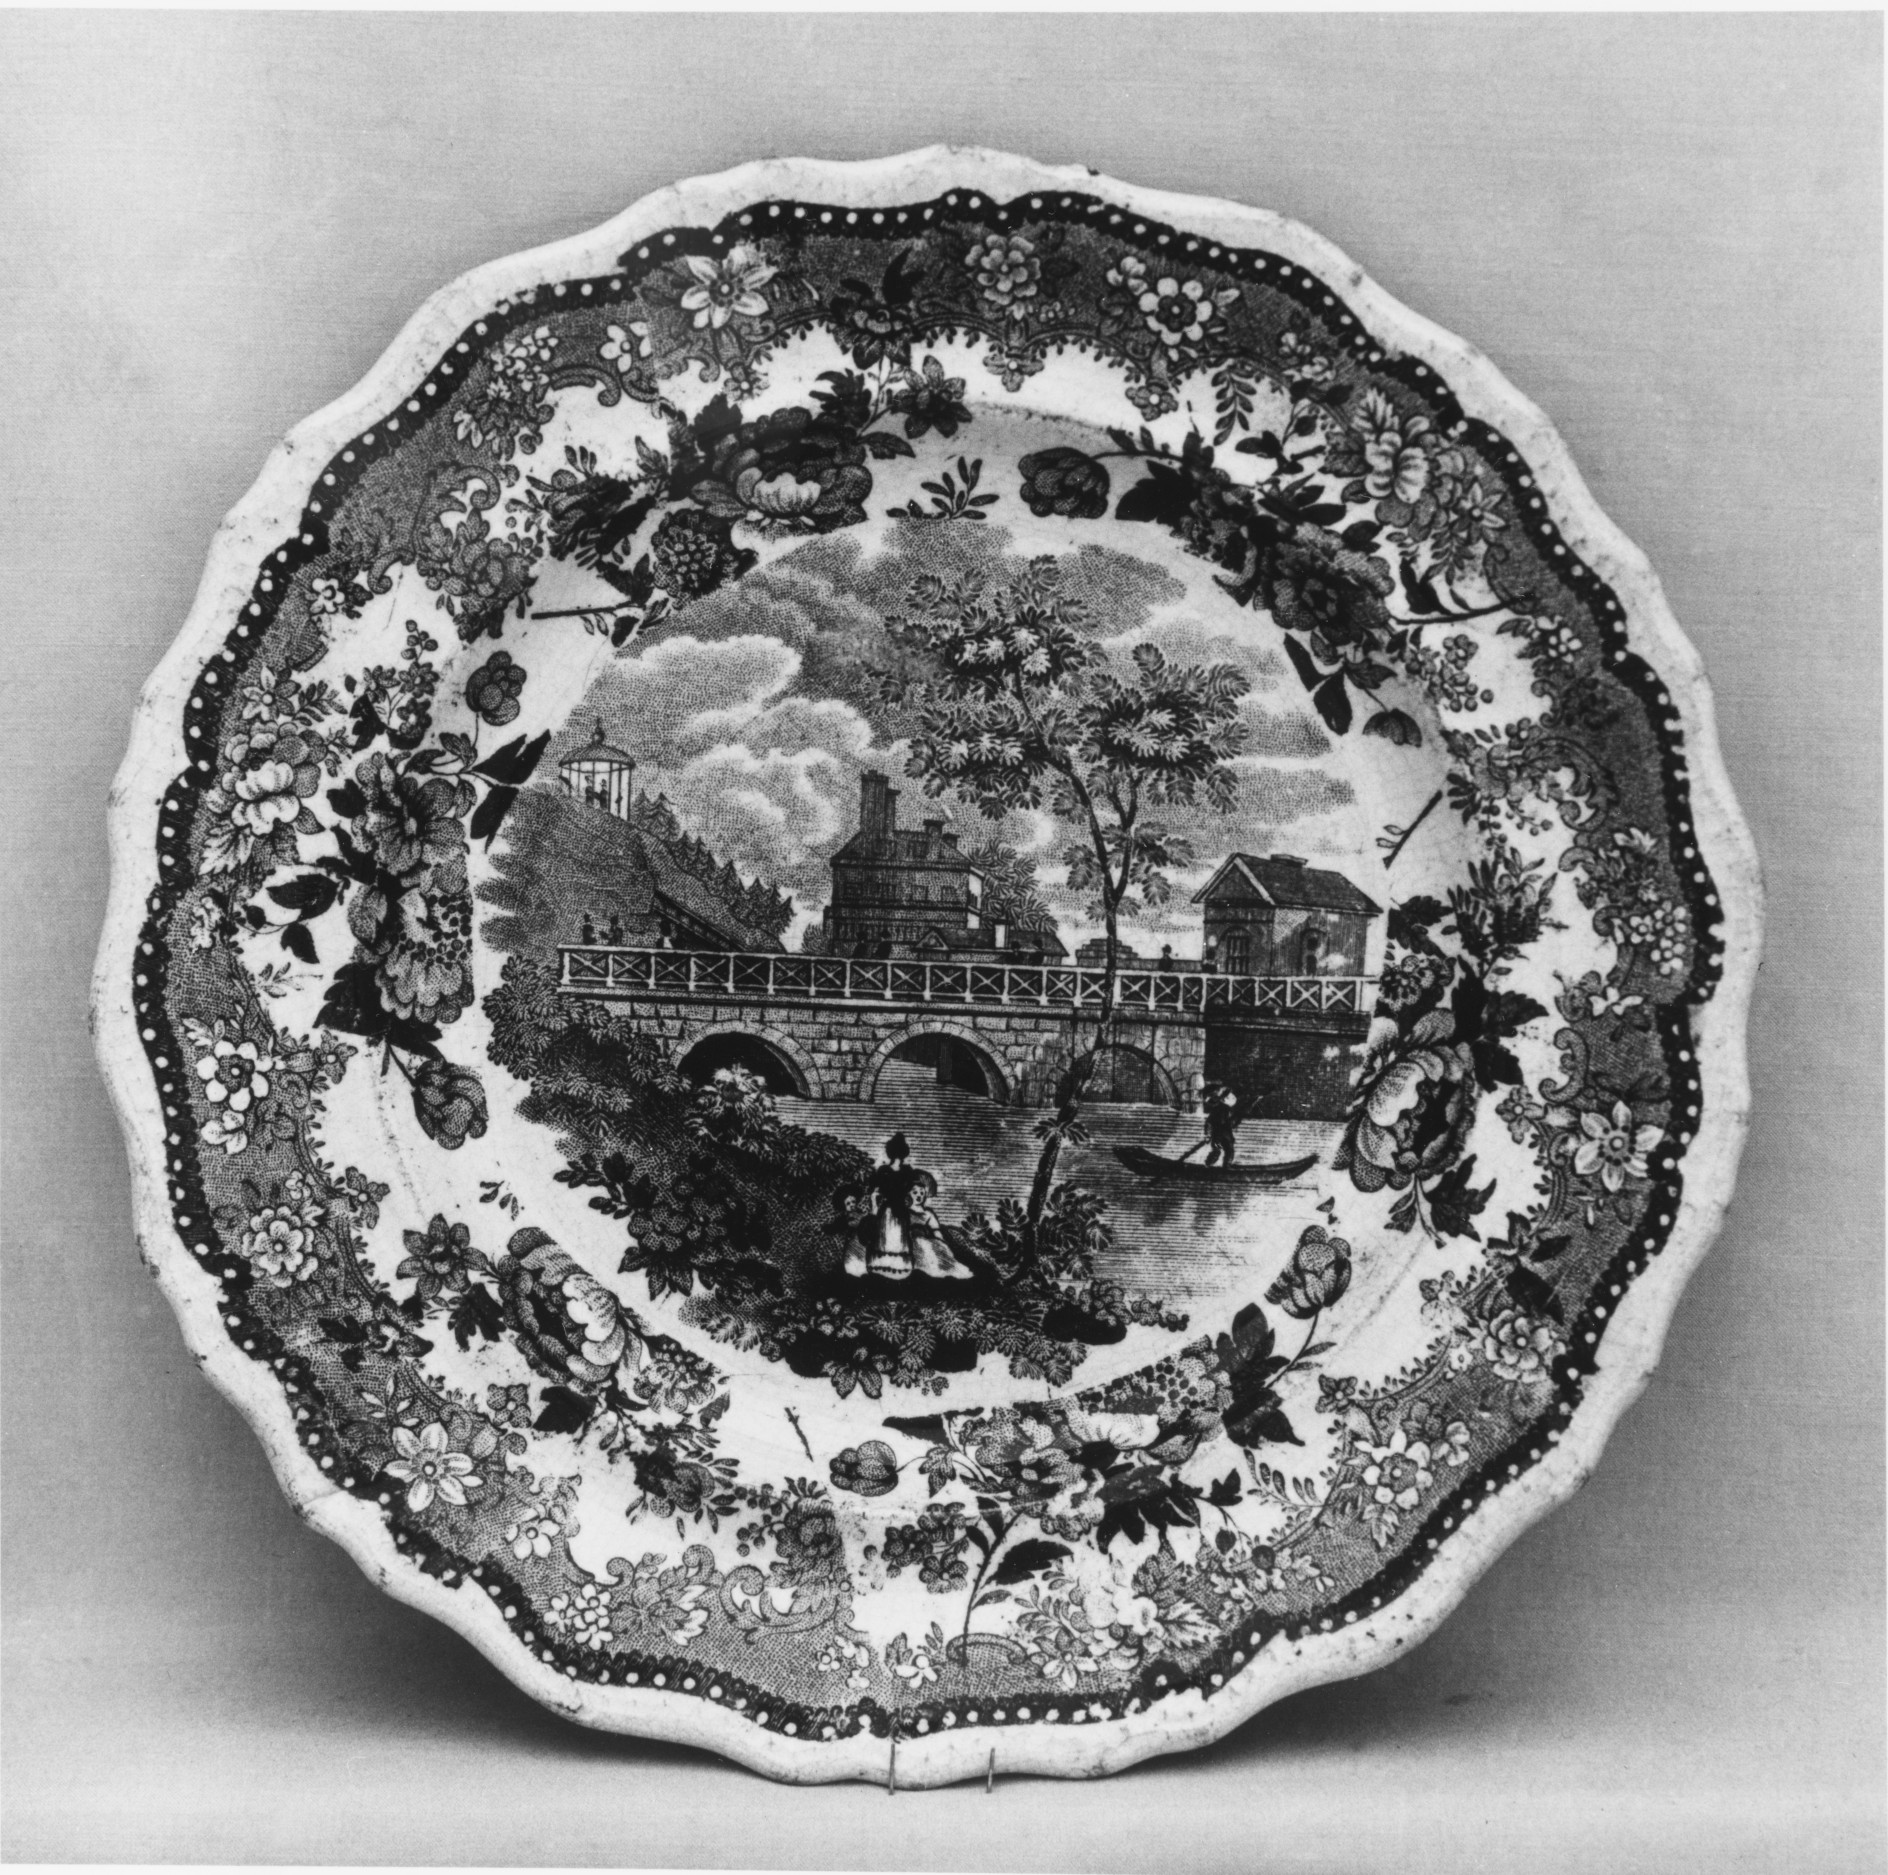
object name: plate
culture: british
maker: job & john jackson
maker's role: maker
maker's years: 1831-1835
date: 1831-1835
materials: earthenware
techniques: transfer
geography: england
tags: bridges,flowers